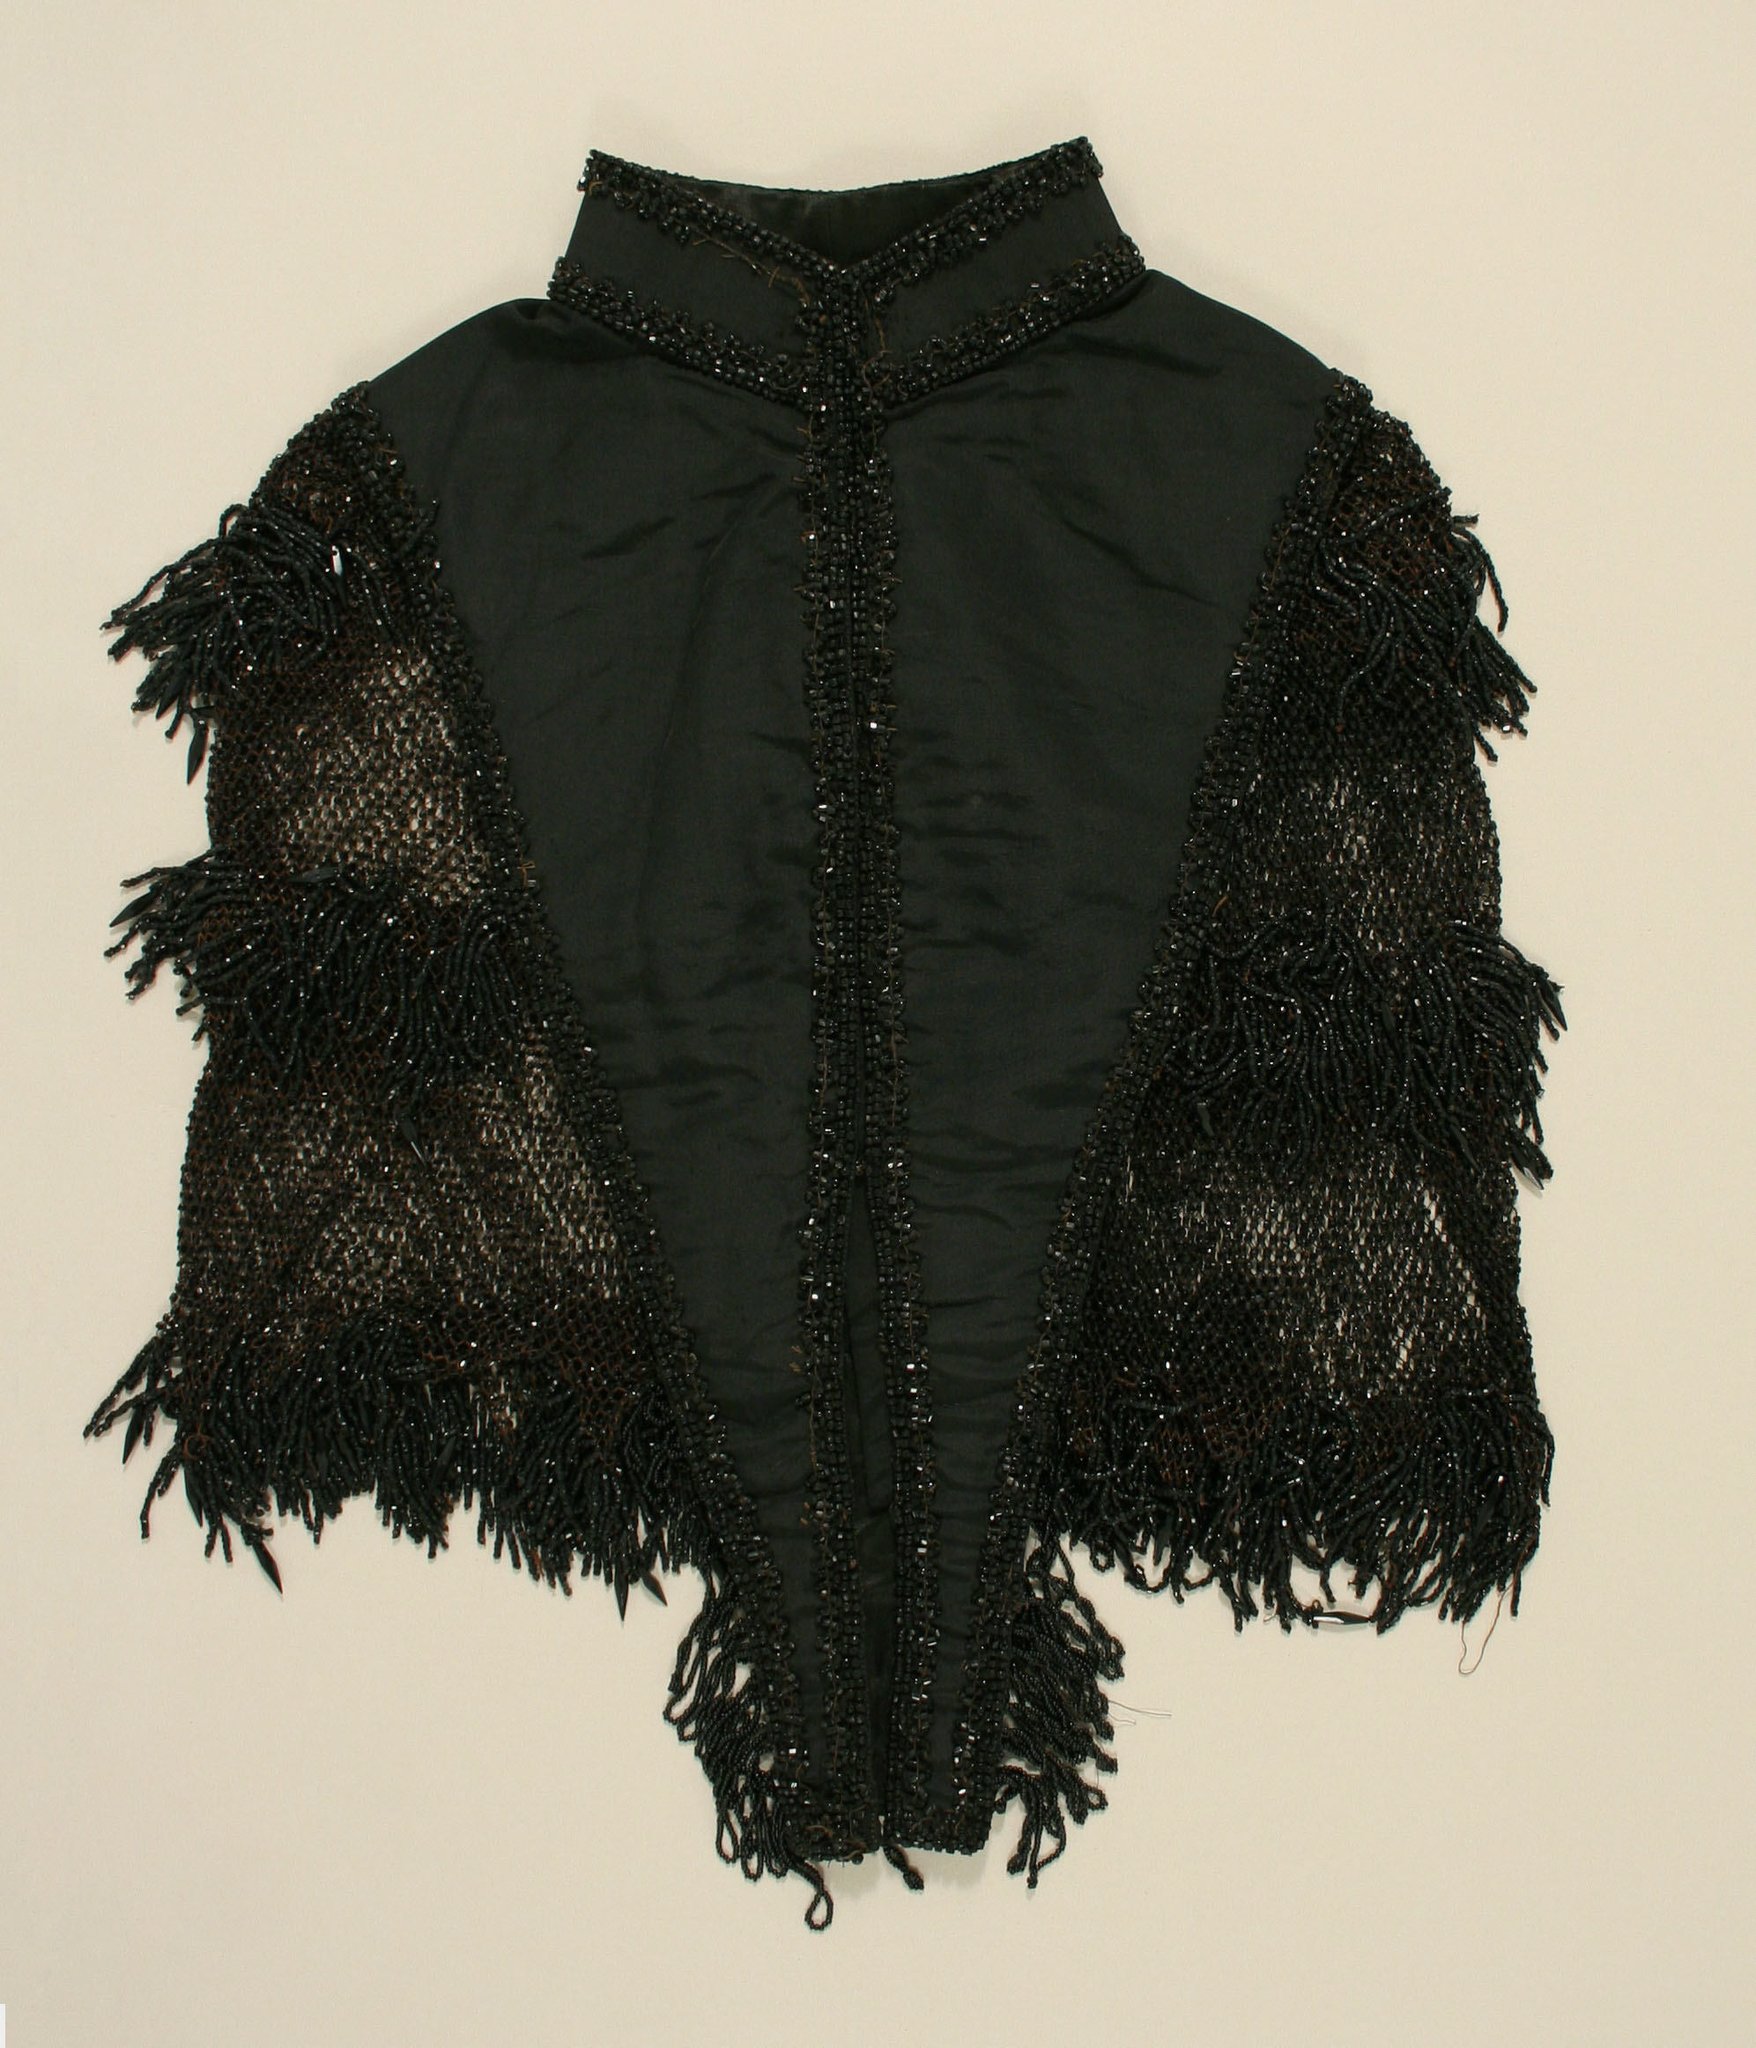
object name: cape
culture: american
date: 1885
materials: silk